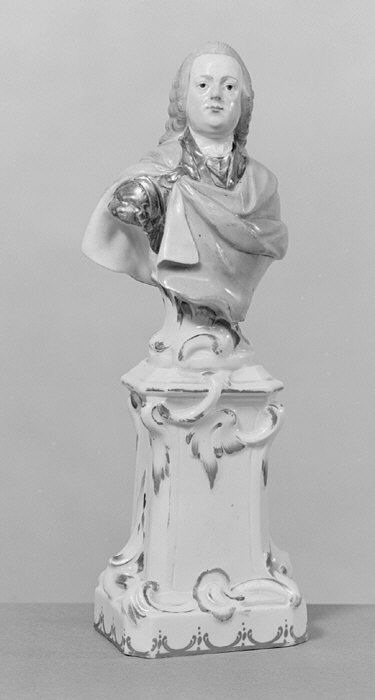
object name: bust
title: Francis I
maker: imperial porcelain manufactory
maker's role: manufactory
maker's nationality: austrian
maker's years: 1744-1864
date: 1760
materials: hard paste porcelain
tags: men,portraits